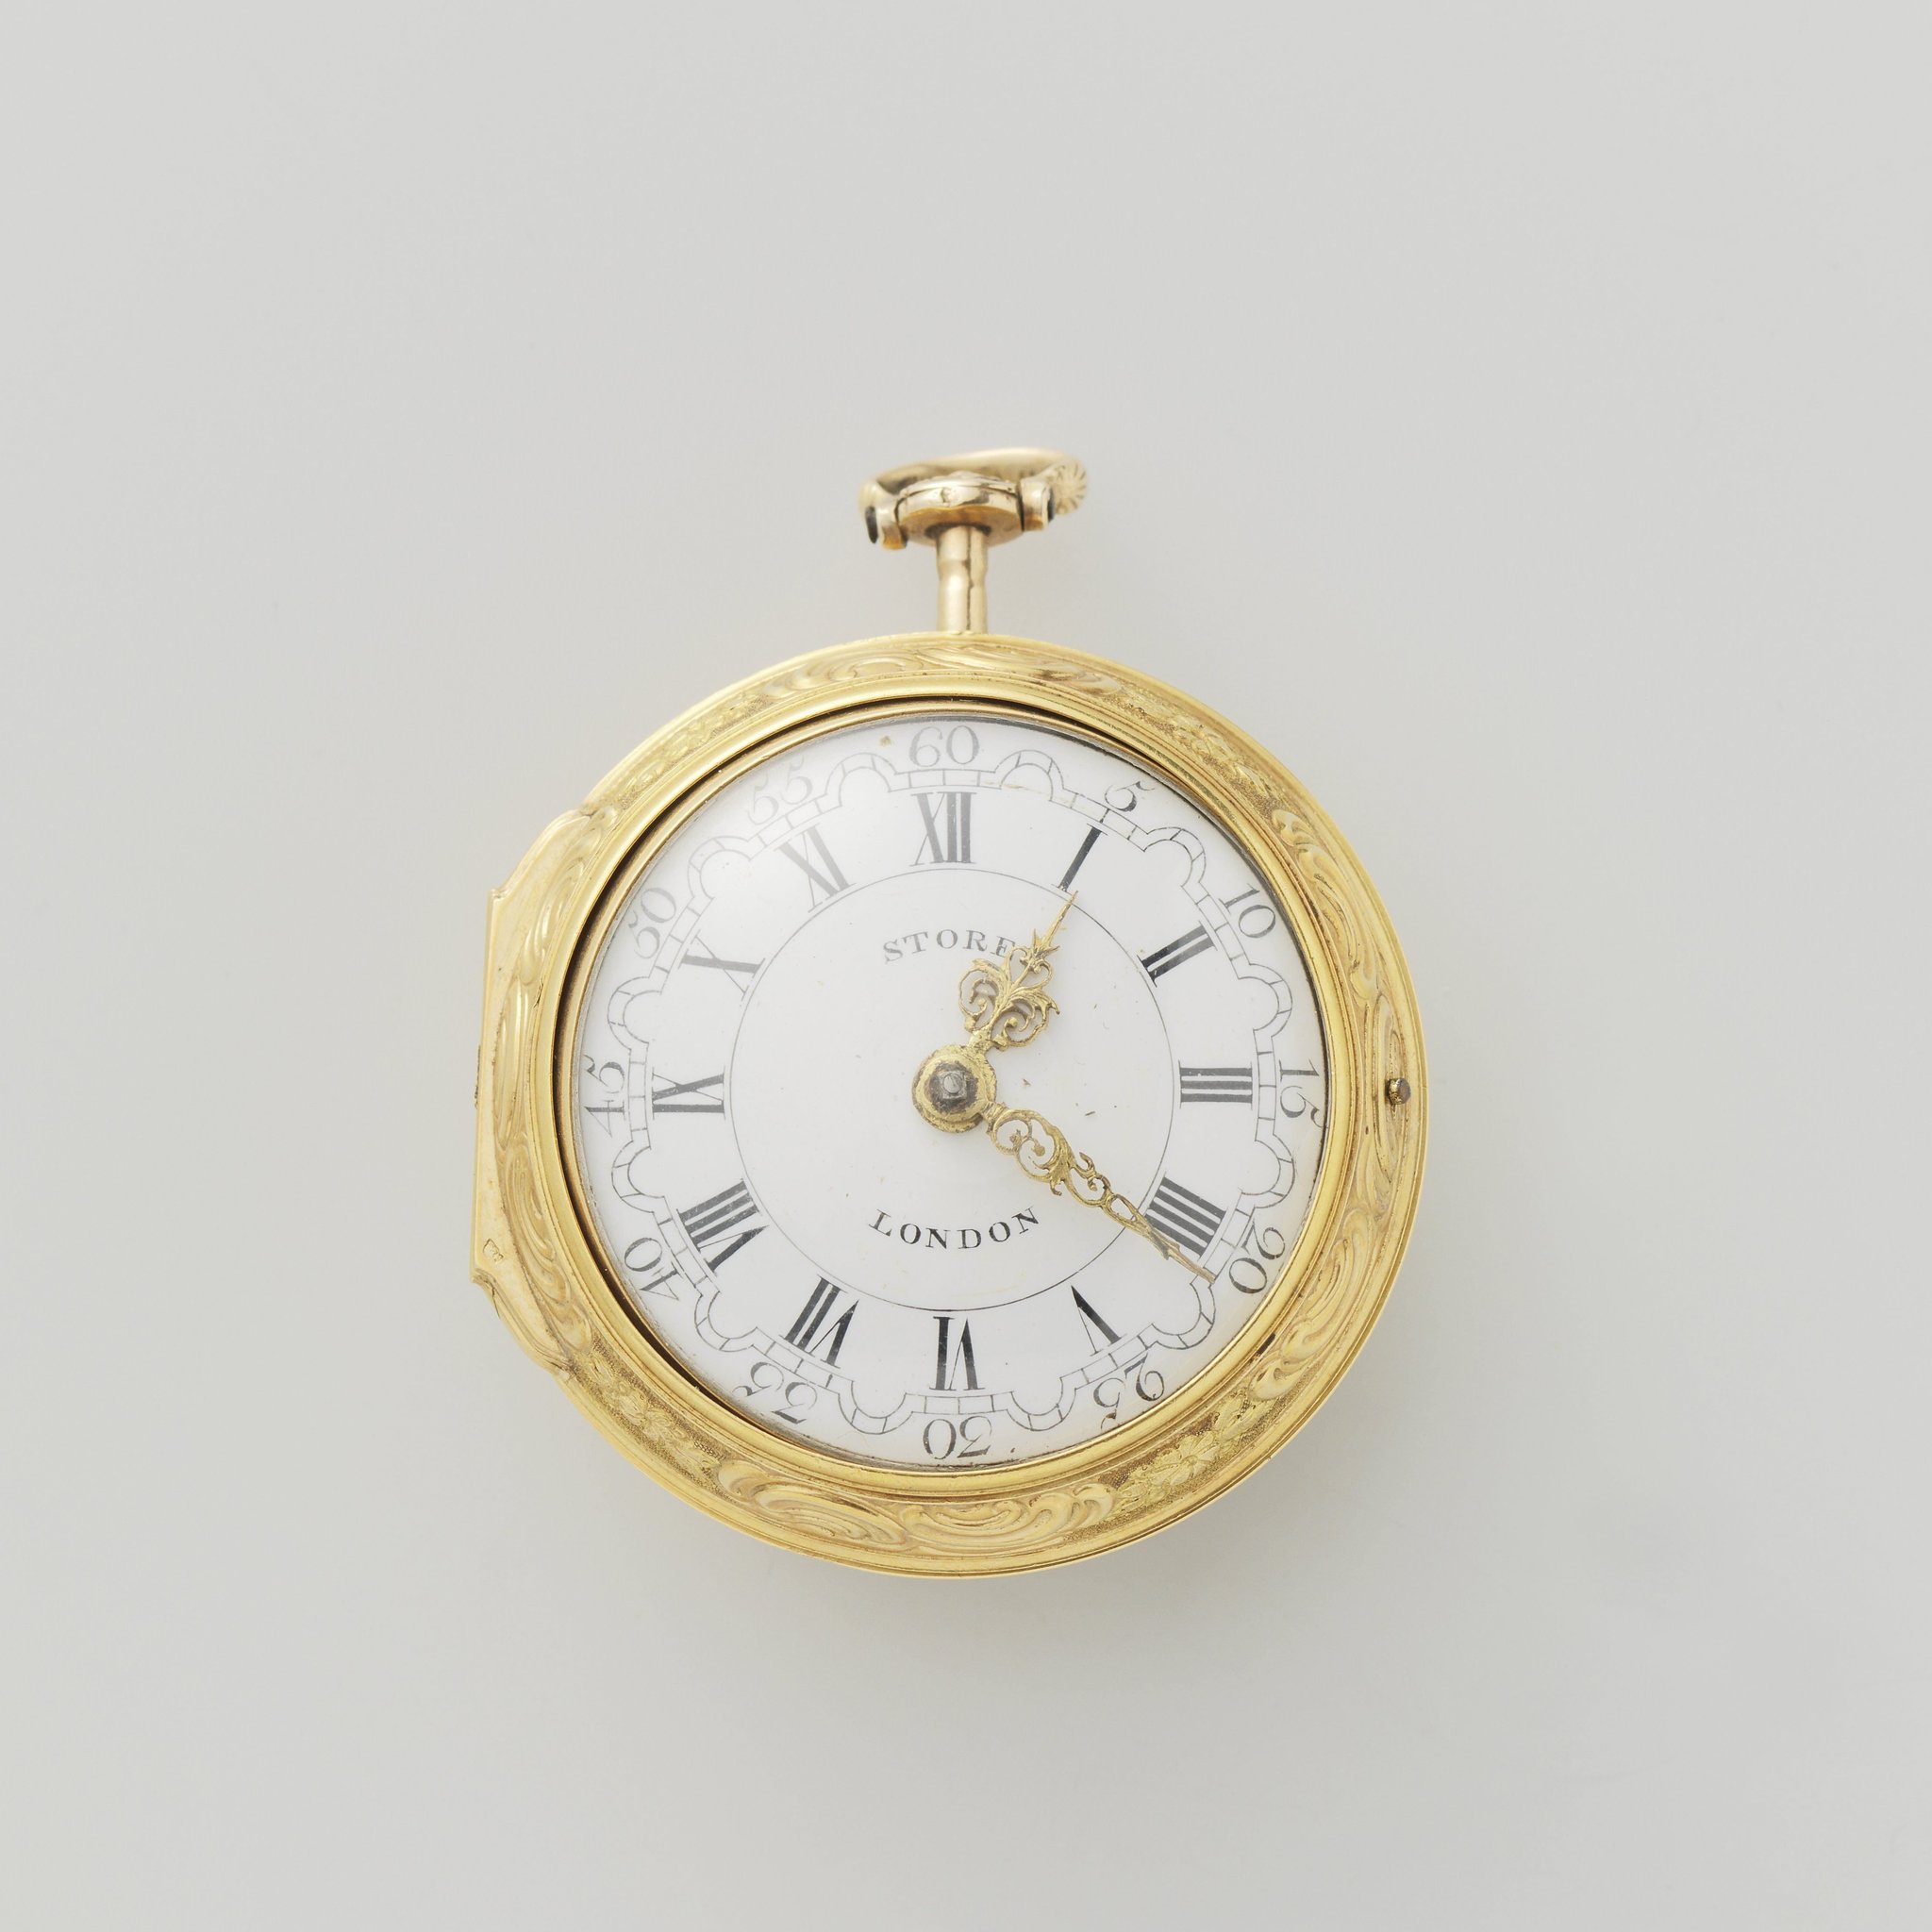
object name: wrist watch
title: Watch with the Judgement of Paris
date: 1774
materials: gold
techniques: repoussé, enameling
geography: london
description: Horloge van goud in dubbele kast. Op de kast een gedreven tafereel voorstellende het oordeel van Paris.